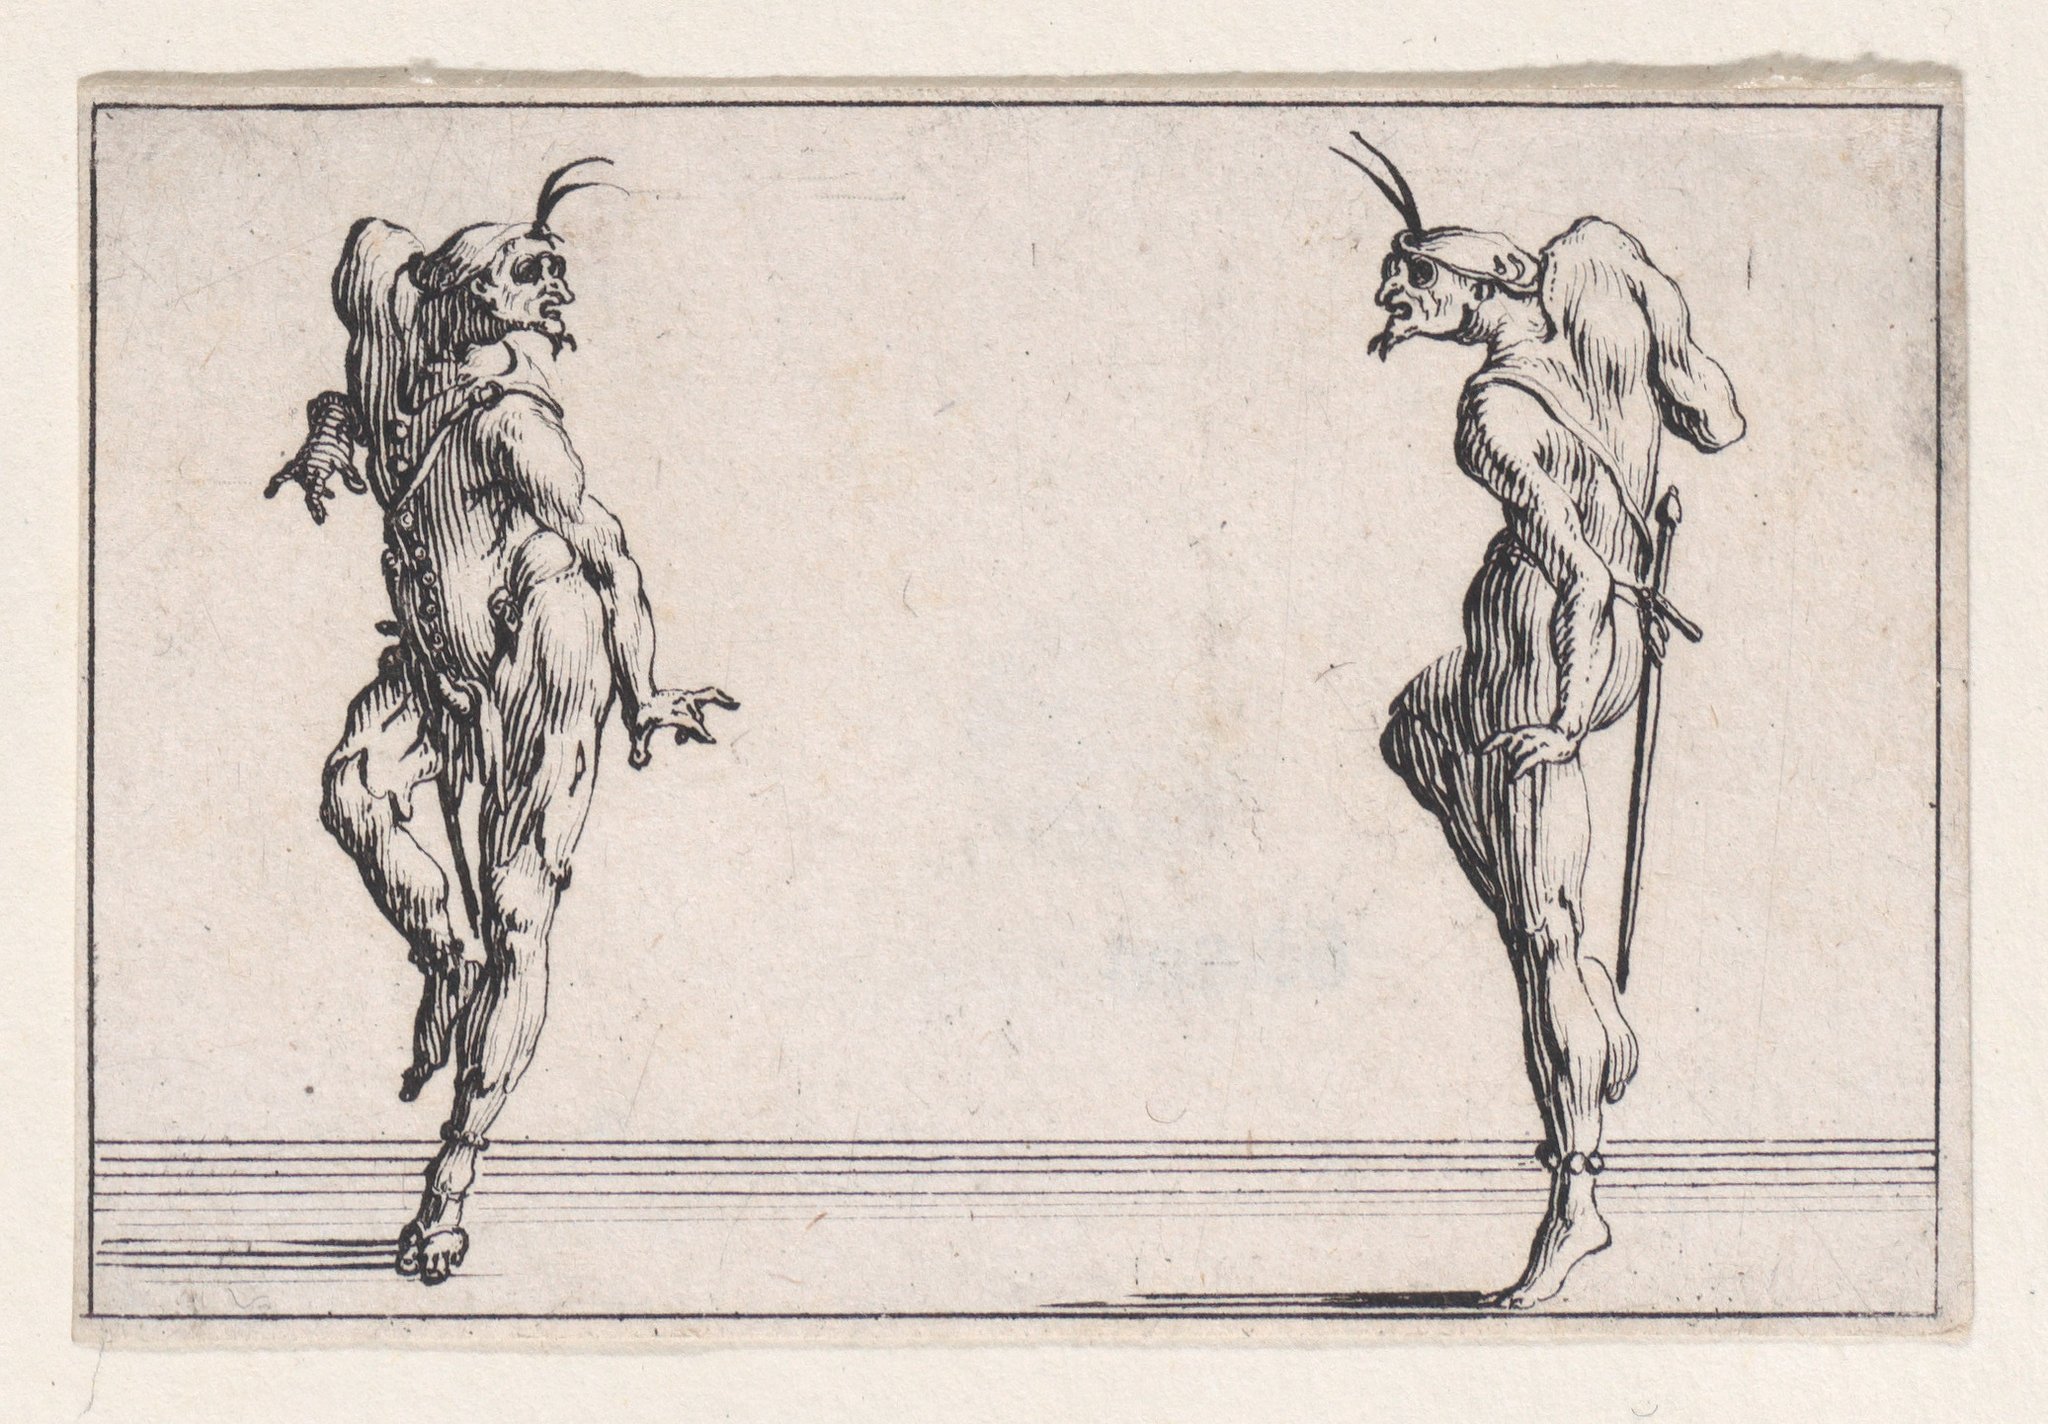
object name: print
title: Les Deux Pantalons se Regardant (Men in Pantsuits Looking at Each Other), from Les Caprices Series A, The Florence Set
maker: jacques callot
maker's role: artist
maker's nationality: french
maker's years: 1592-1635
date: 1617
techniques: etching